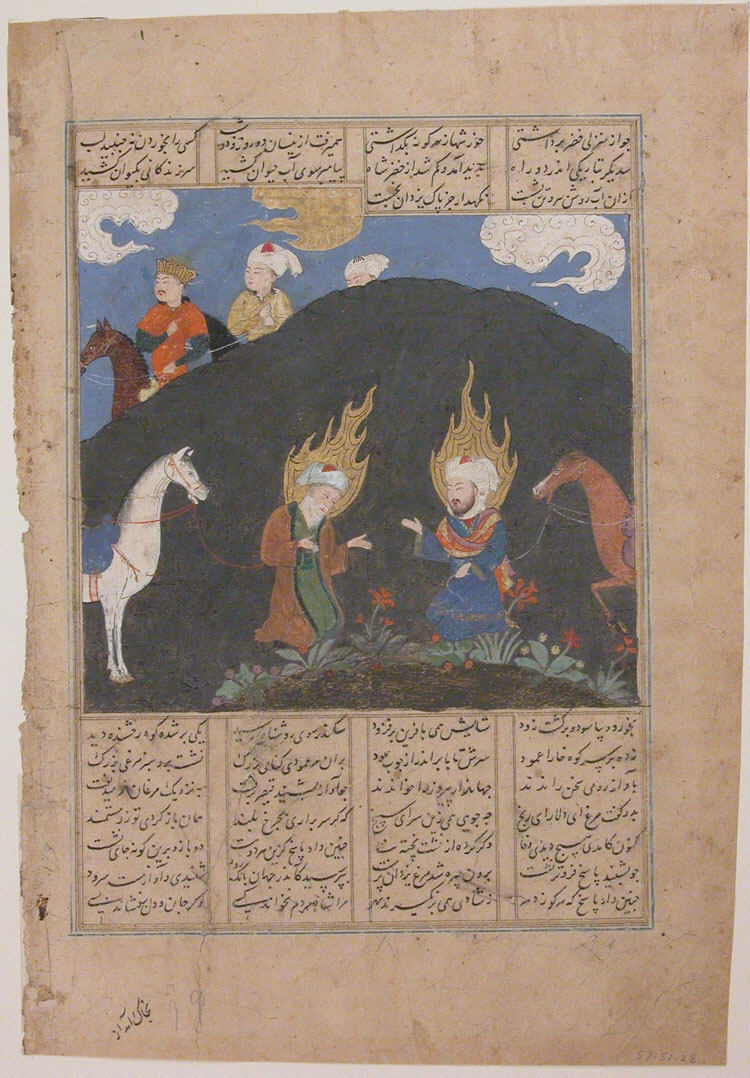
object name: folio from an illustrated manuscript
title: "Elias and Khizr at the Fountain of Life', Folio from a Shahnama (Book of Kings) of Firdausi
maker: abu'l qasim firdausi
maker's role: author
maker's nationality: iranian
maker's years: 935-1020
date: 1467-1500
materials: gold, ink, paper, watercolor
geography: iran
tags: alexander the great,men,horses